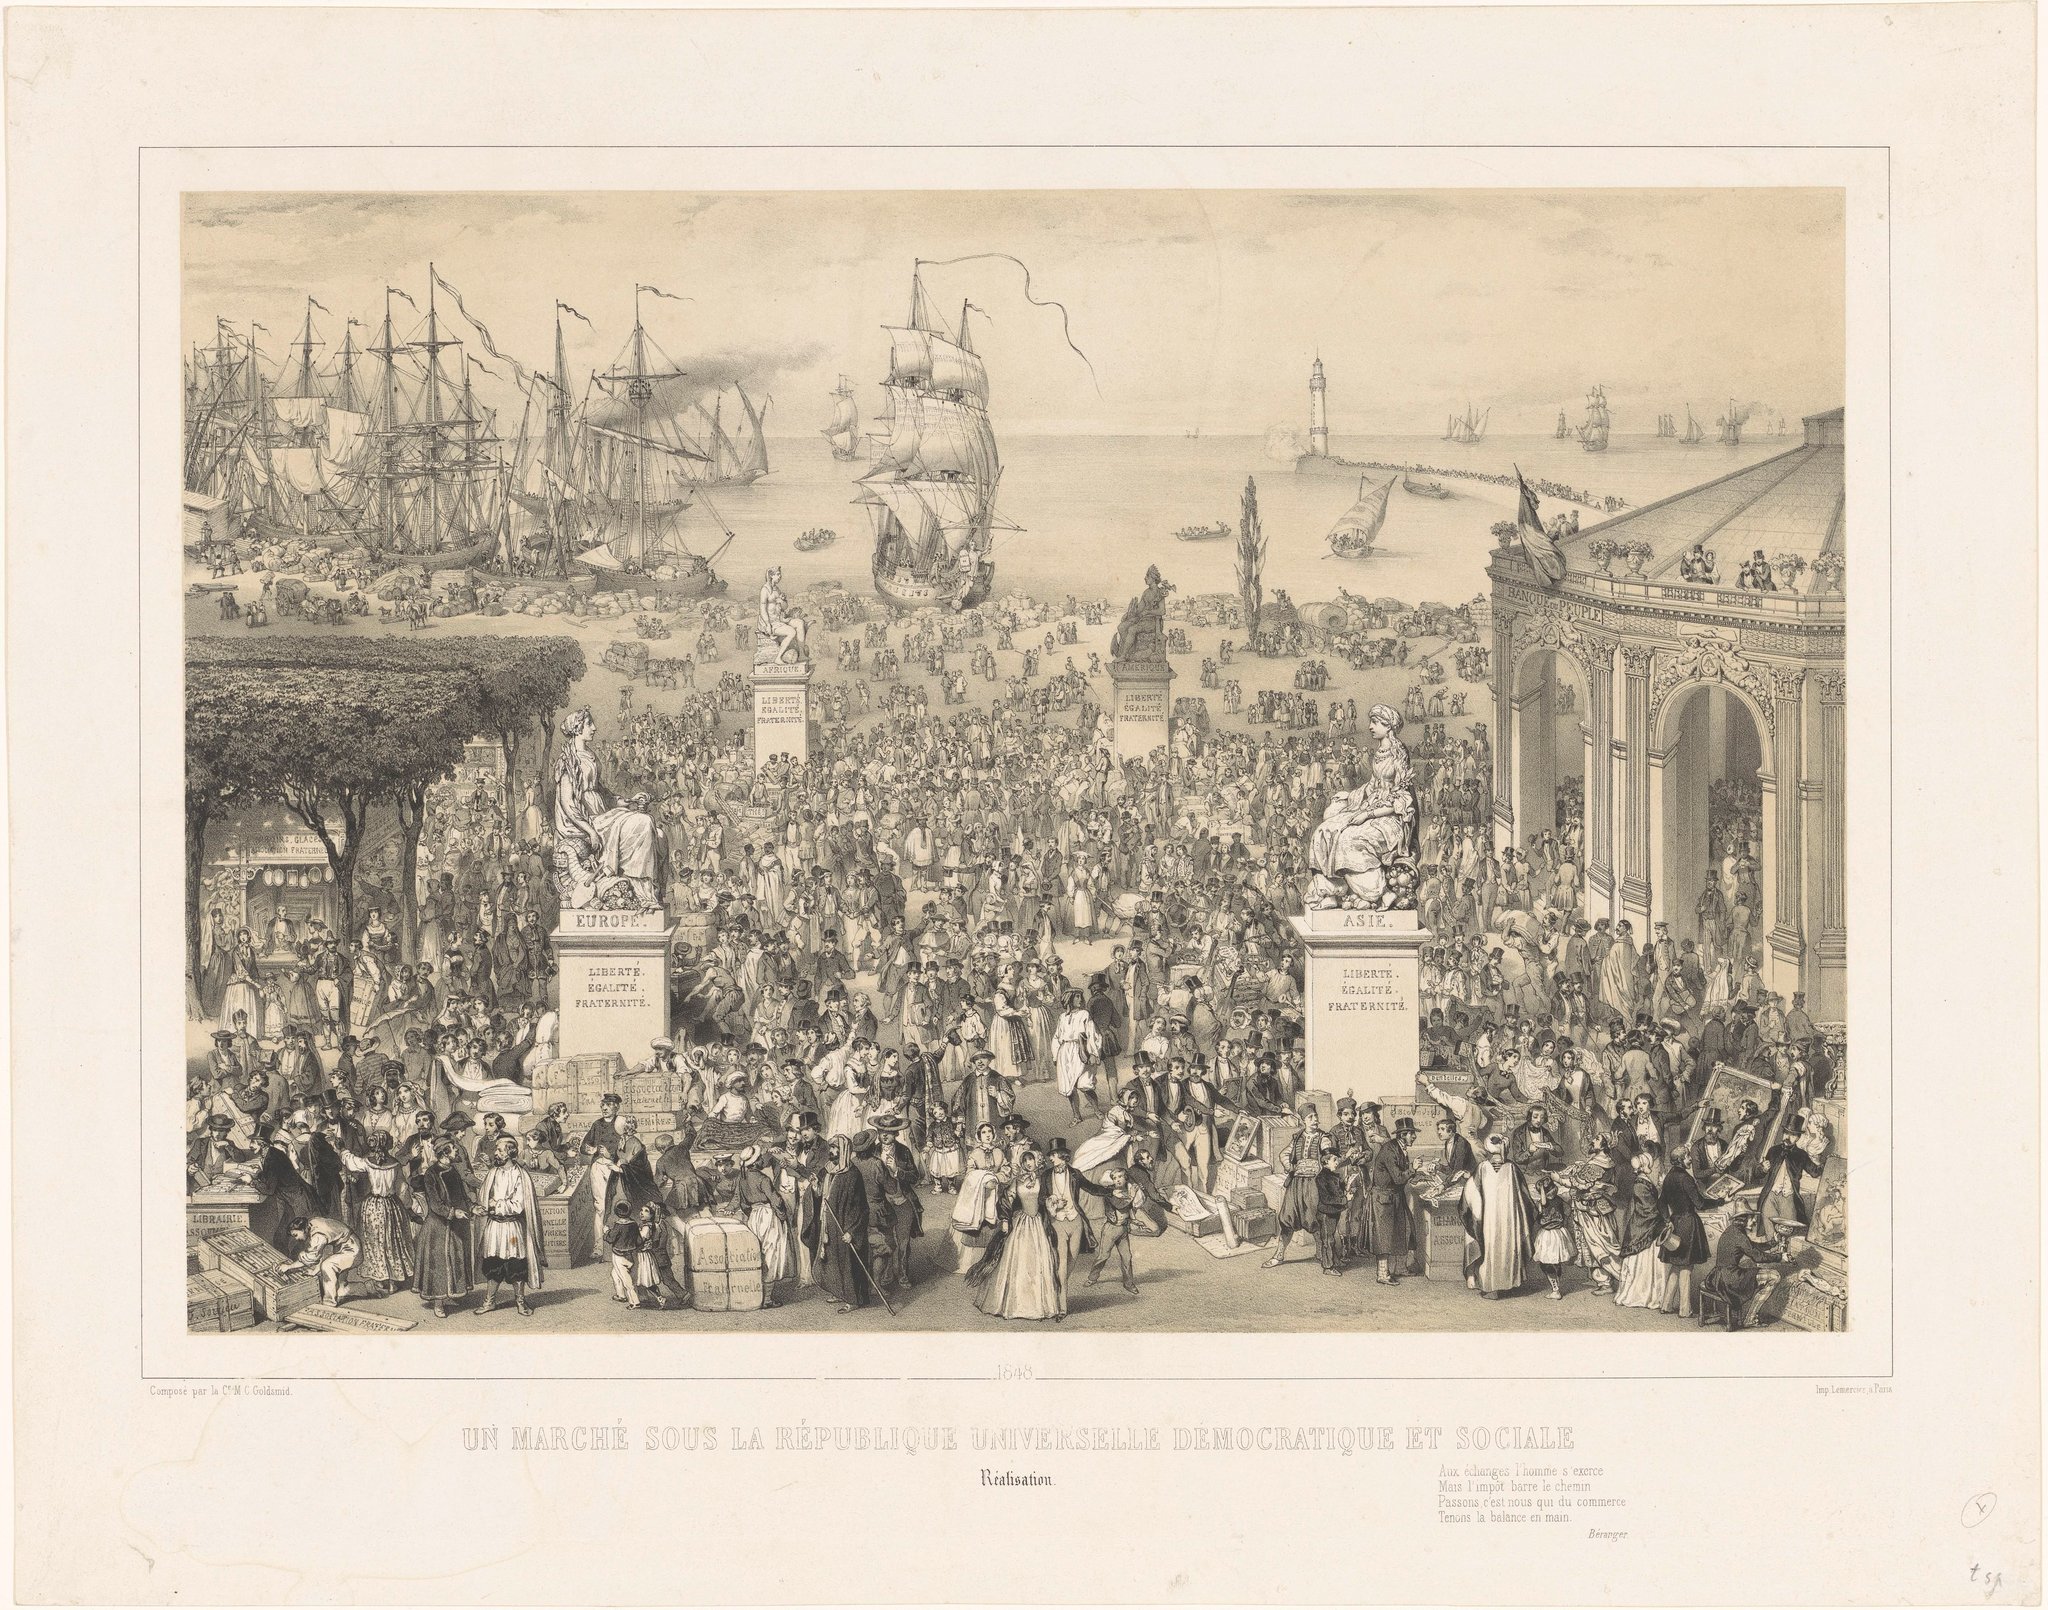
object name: print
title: Un marché sous la république universelle democraqtique et sociale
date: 1848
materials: paper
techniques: tone lithography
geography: paris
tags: sailing-ship, sailing-boat, market, continents represented allegorically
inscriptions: collector's mark: Lugt 2228, collector's mark: Lugt 4780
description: De utopie van vrije wereldhandel voorgesteld als een marktplein waar mensen uit alle windstreken met elkaar handel drijven. Te zien zijn onder meer handelaren in boeken, stoffen, prenten, muziekinstrumenten, kunst en schilderijen. Op het plein staan standbeelden met de personificaties van de vier continenten, elk met het motto 'Liberté Égalité Fraternité' op de sokkel. Links een gebouw met op de gevel 'Banque du peuple'. In de achtergrond leggen zeilschepen aan. Met vierregelig gedicht door Pierre-Jean de Béranger onder de afbeelding.